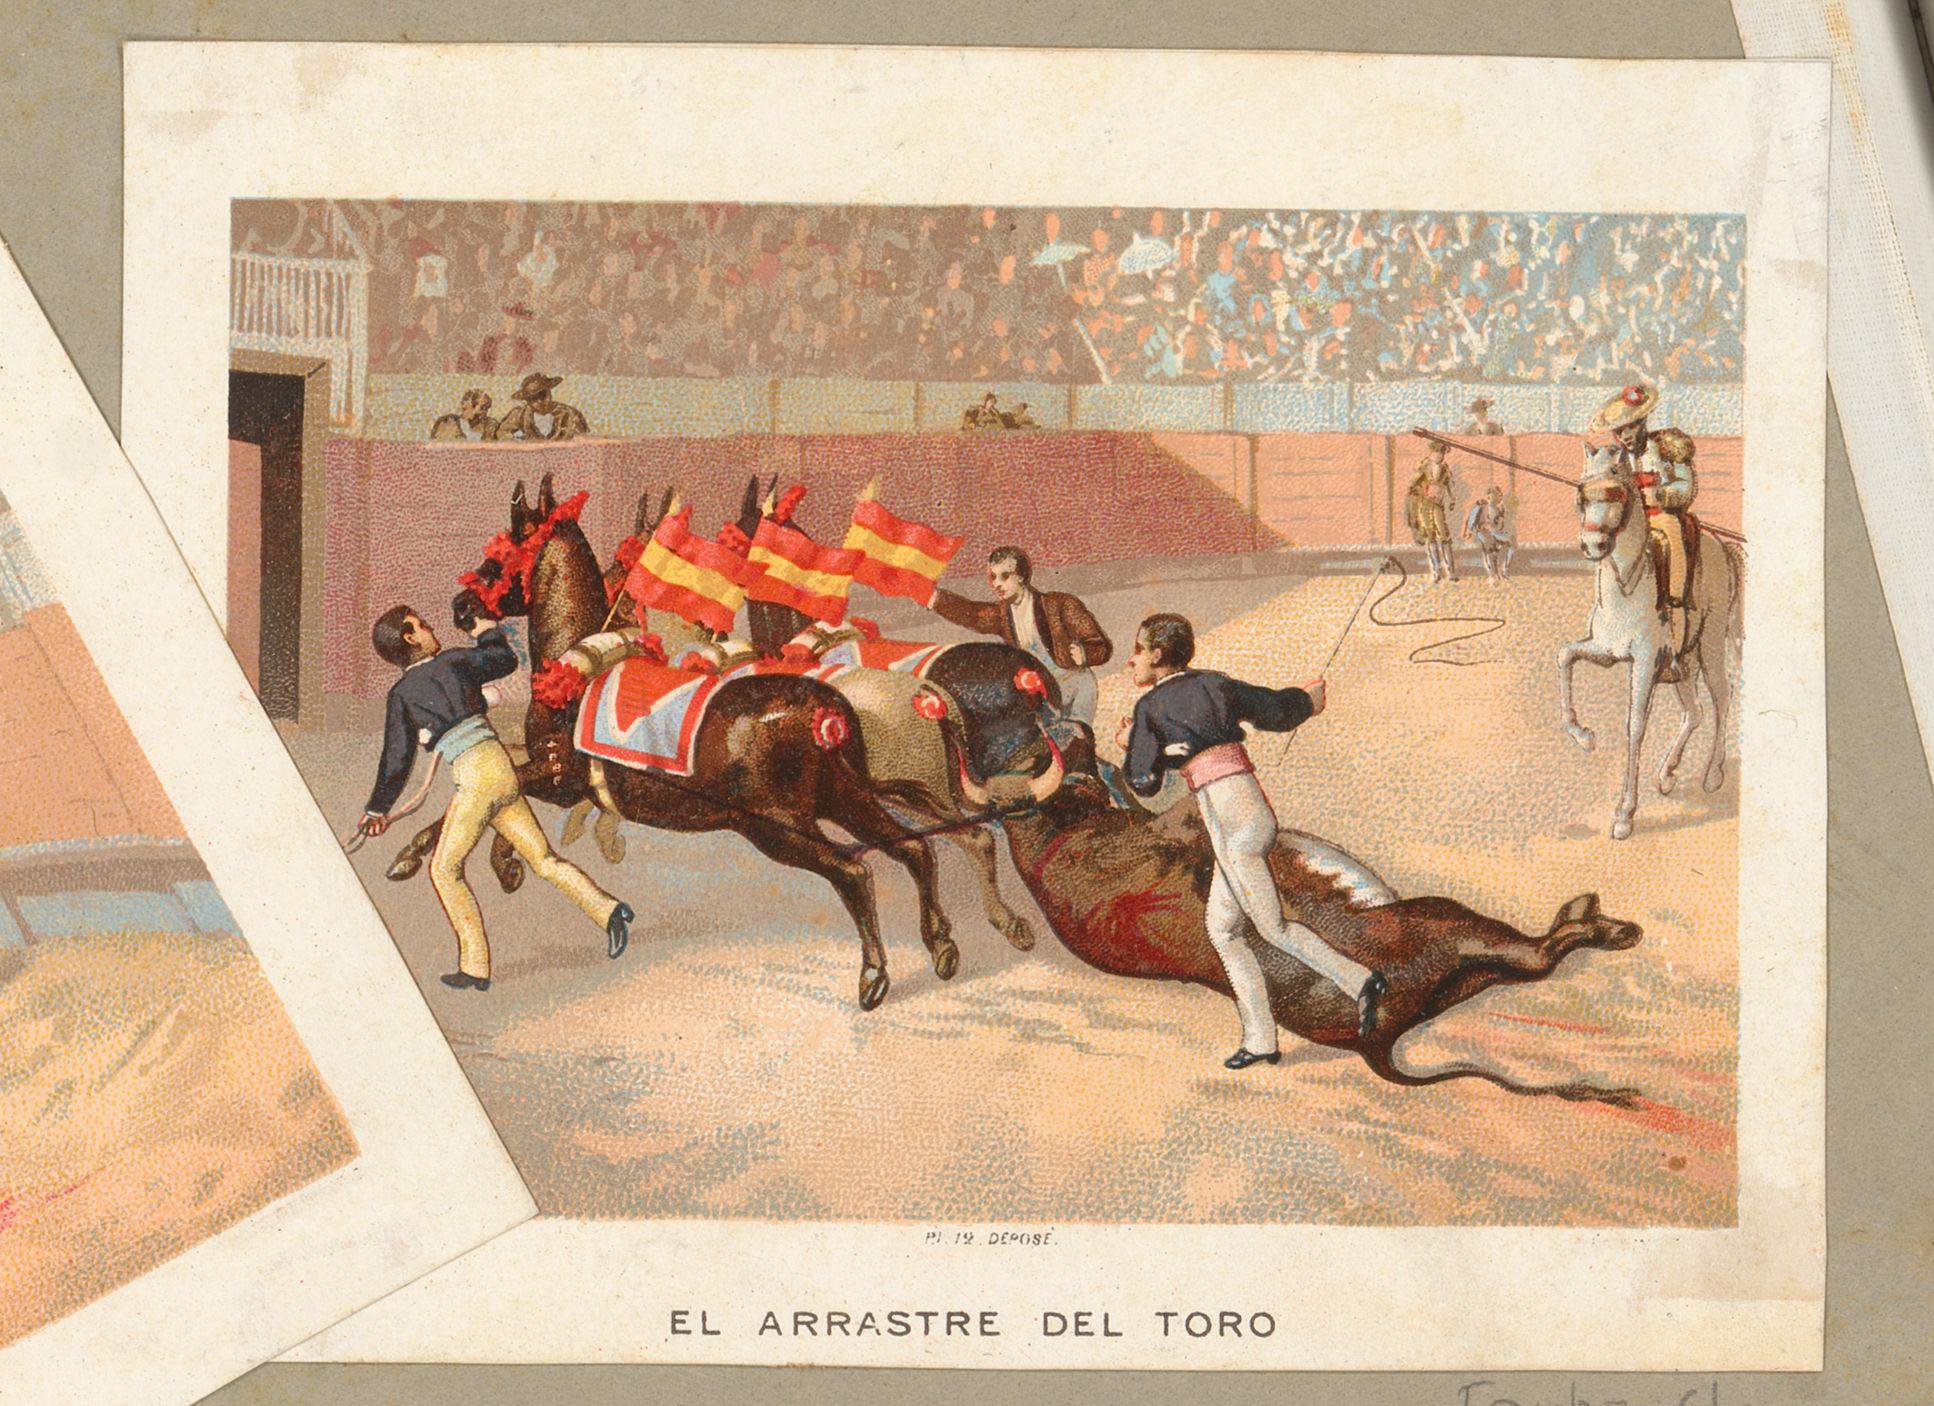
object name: album leaf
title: El arrastre del toro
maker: Anonymous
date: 1880-1910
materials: paper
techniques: chromolithography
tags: bullfight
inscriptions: inscription: ‘Pl. 12. Déposé’